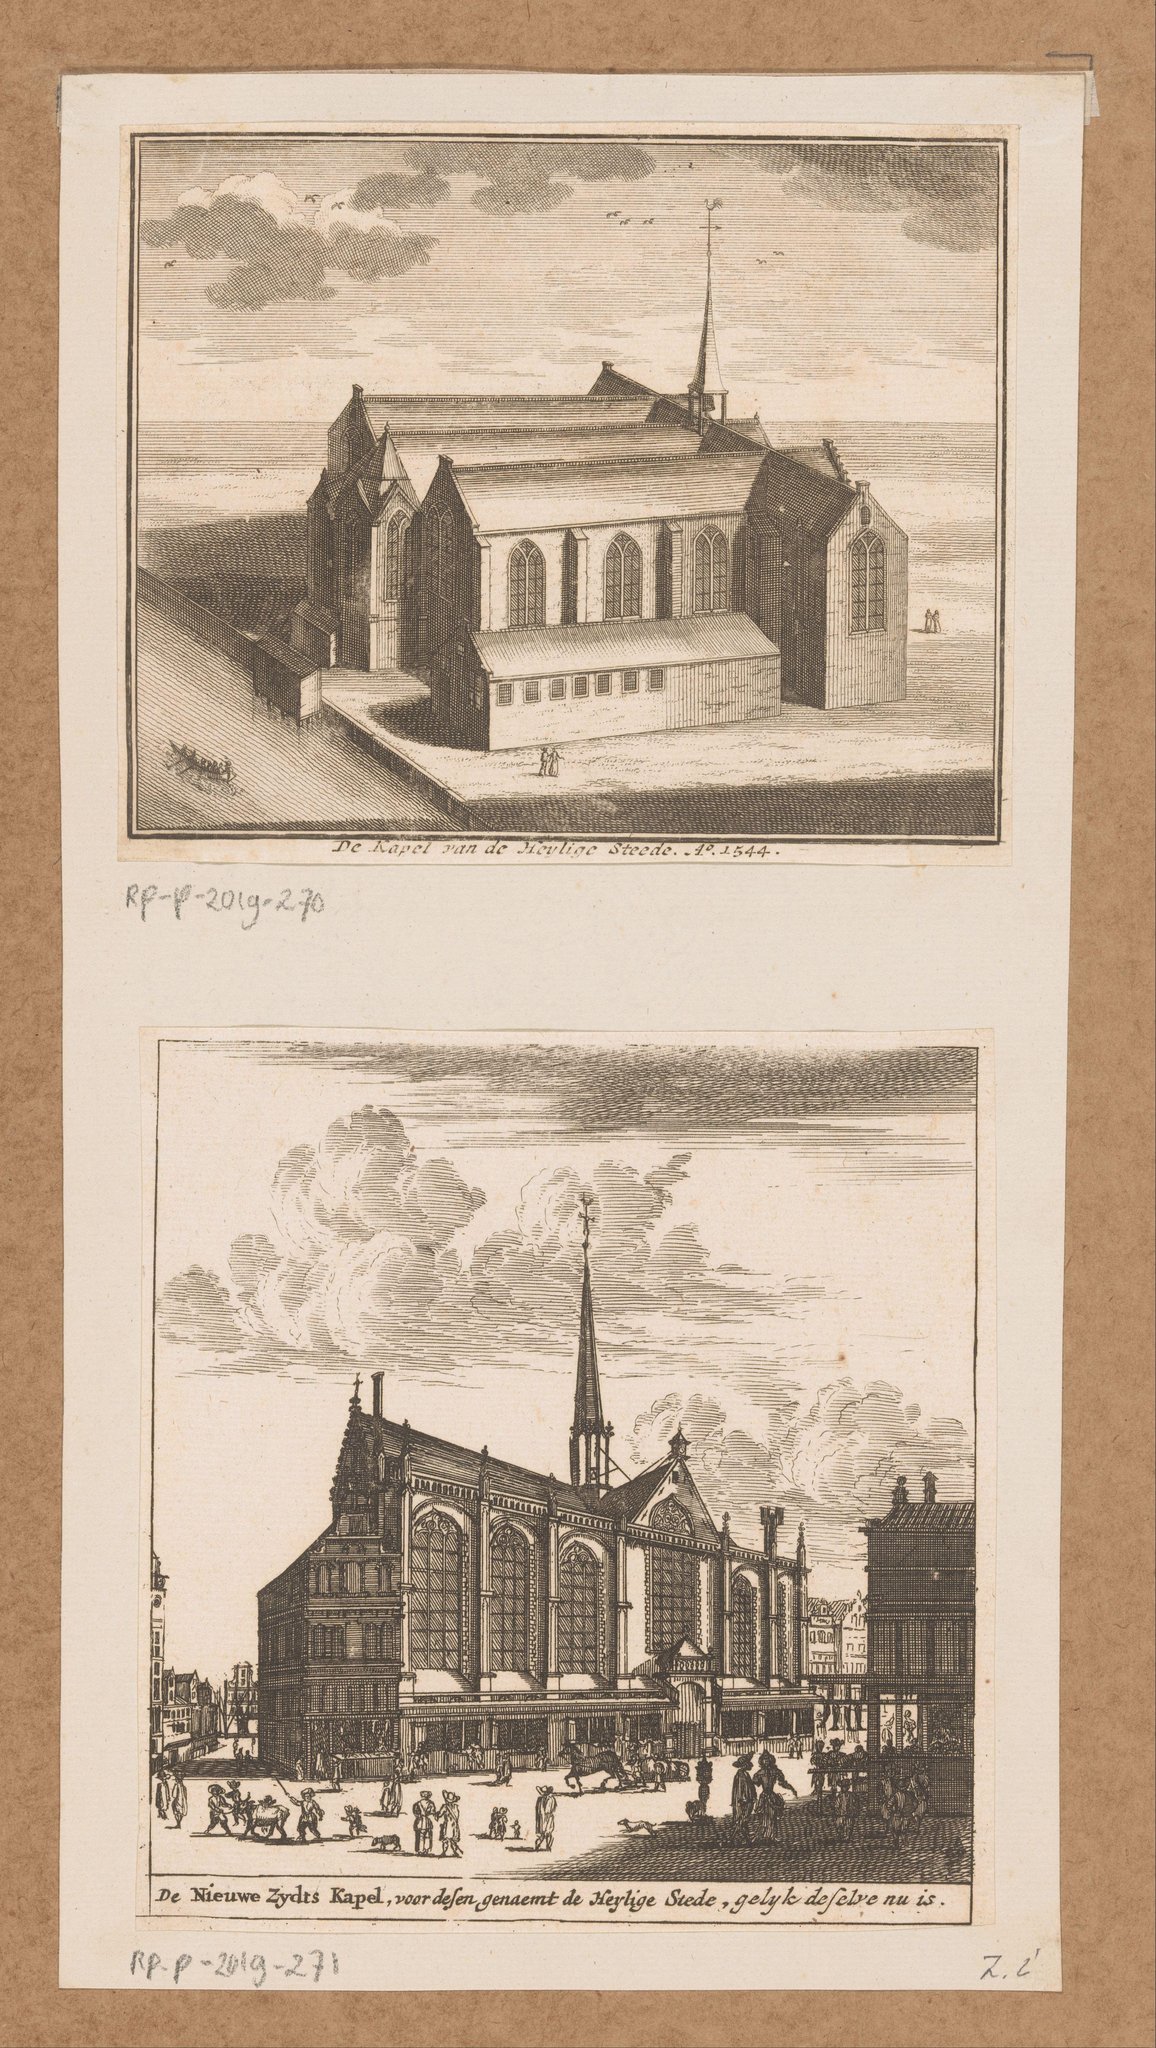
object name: print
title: Gezicht in vogelvlucht op de Heilige Stede te Amsterdam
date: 1729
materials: paper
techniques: etching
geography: amsterdam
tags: church (exterior)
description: Prent uit: Long, Isaac le. Historische beschryvinge van de reformatie der stadt Amsterdam (…). Amsterdam: Johannes van Septeren (I), 1729, tussen p. 330 en 331.